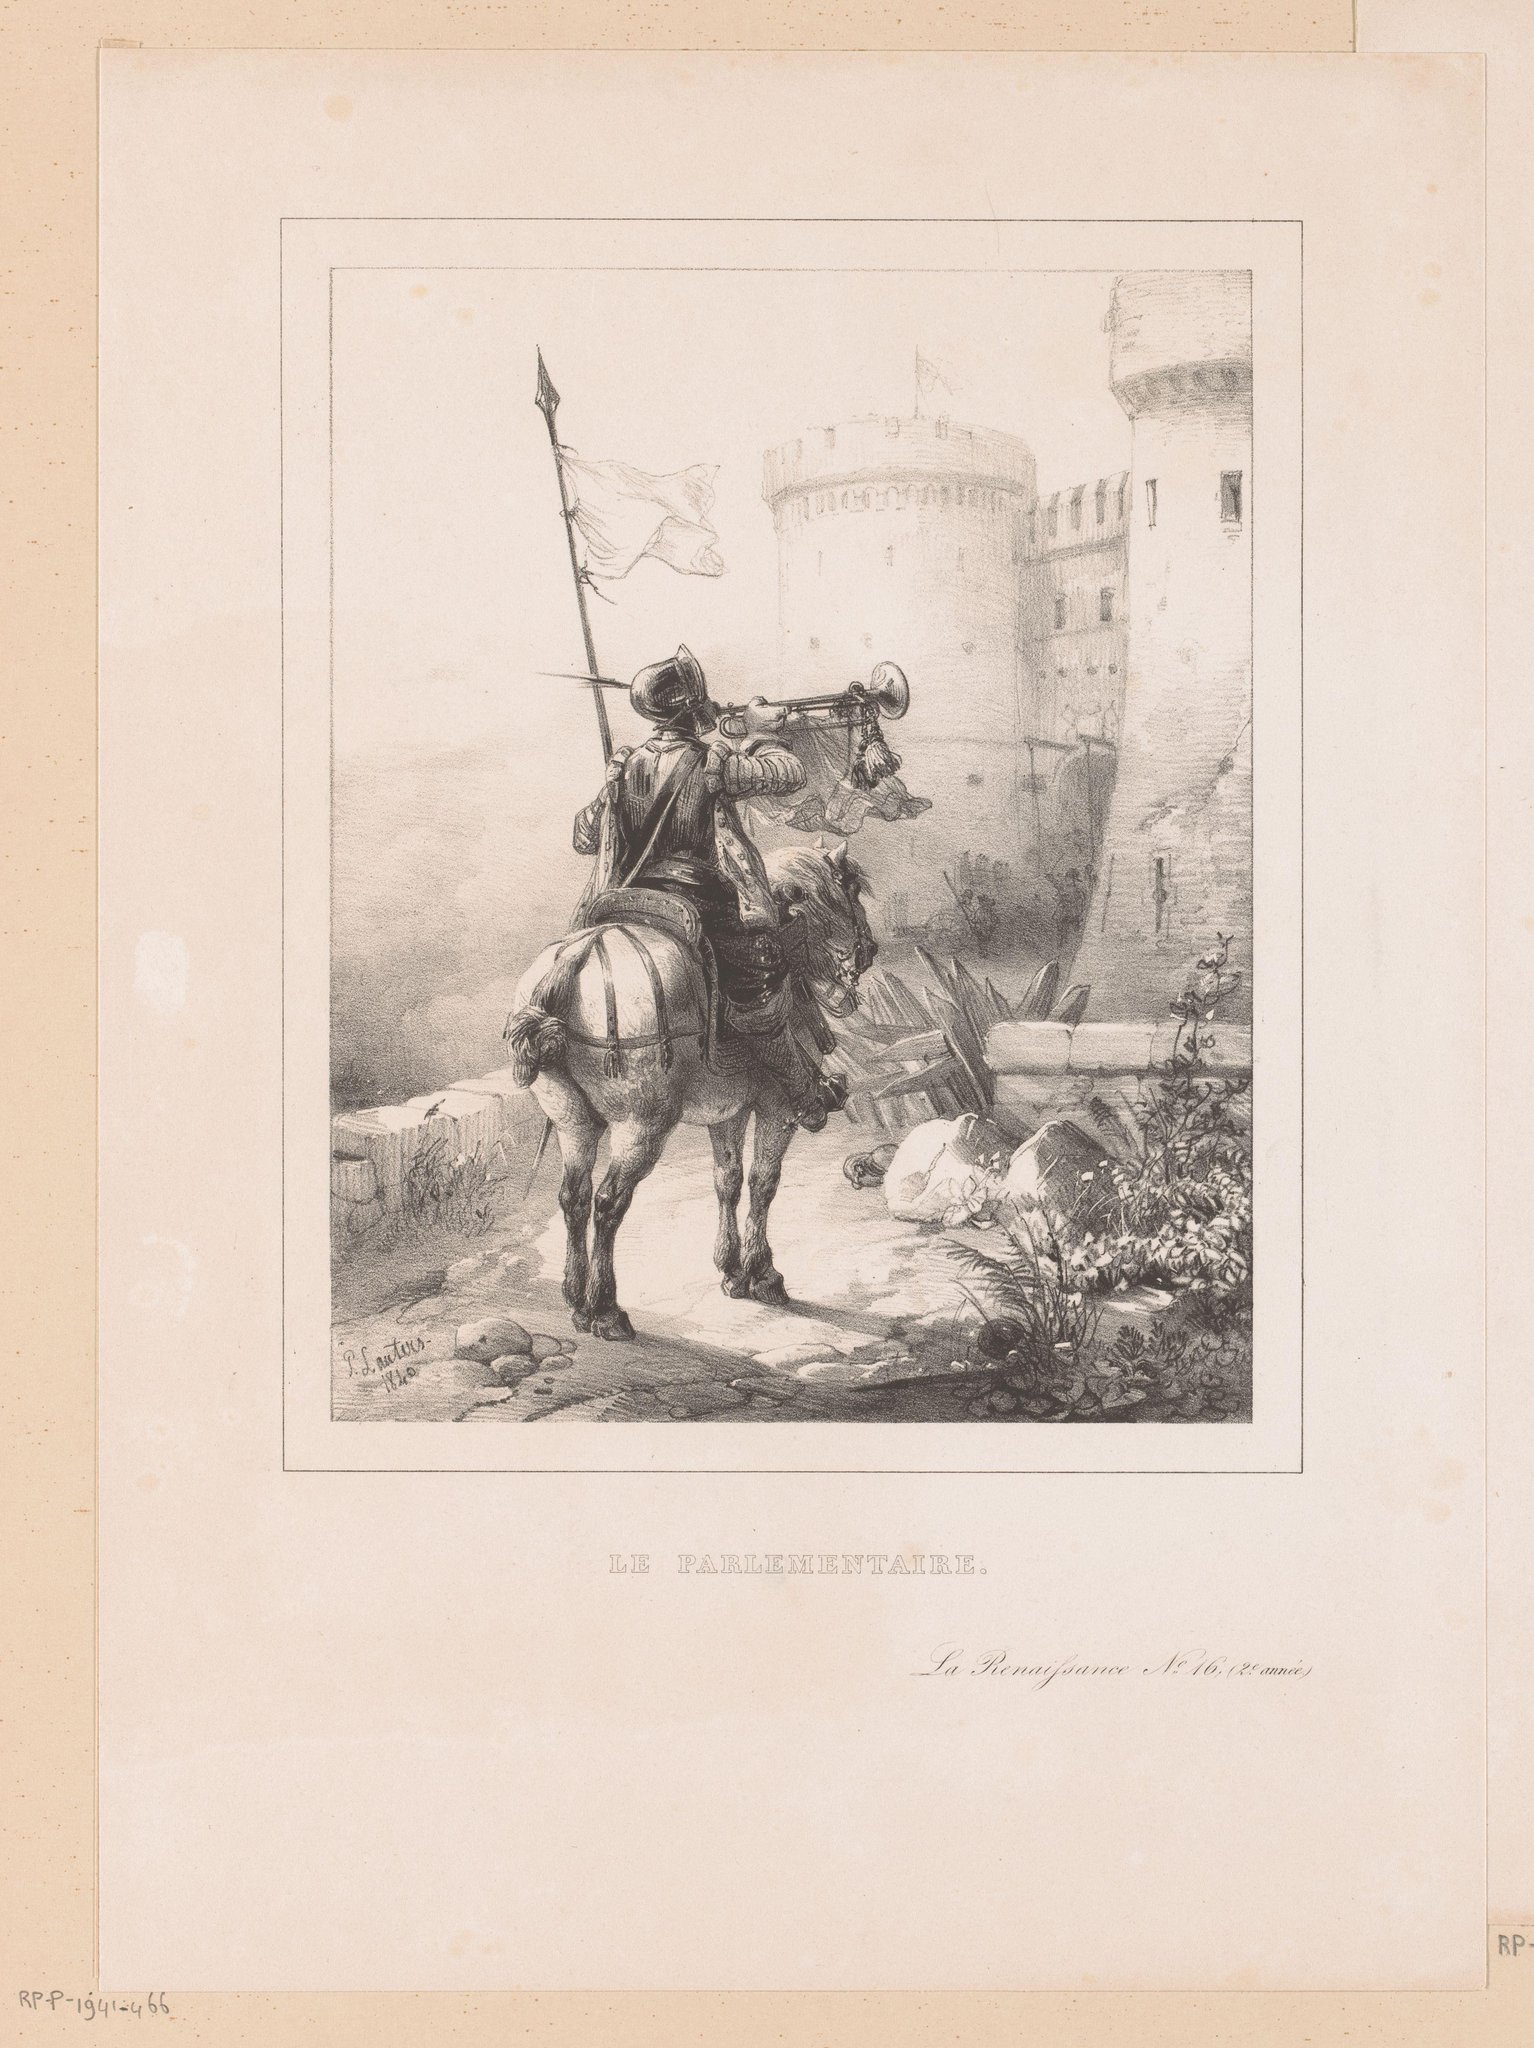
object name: print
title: Heraut met bazuin voor een kasteel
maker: paulus lauters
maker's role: print maker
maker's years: 1806-1875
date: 1840-1841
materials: paper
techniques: lithograph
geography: brussels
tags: castle, herald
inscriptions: collector's mark: Lugt 2228, collector's mark: Lugt 2760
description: Prent uit: La Renaissance. Chronique des arts et de la littérature 2 (1840-1841), pl. 16.